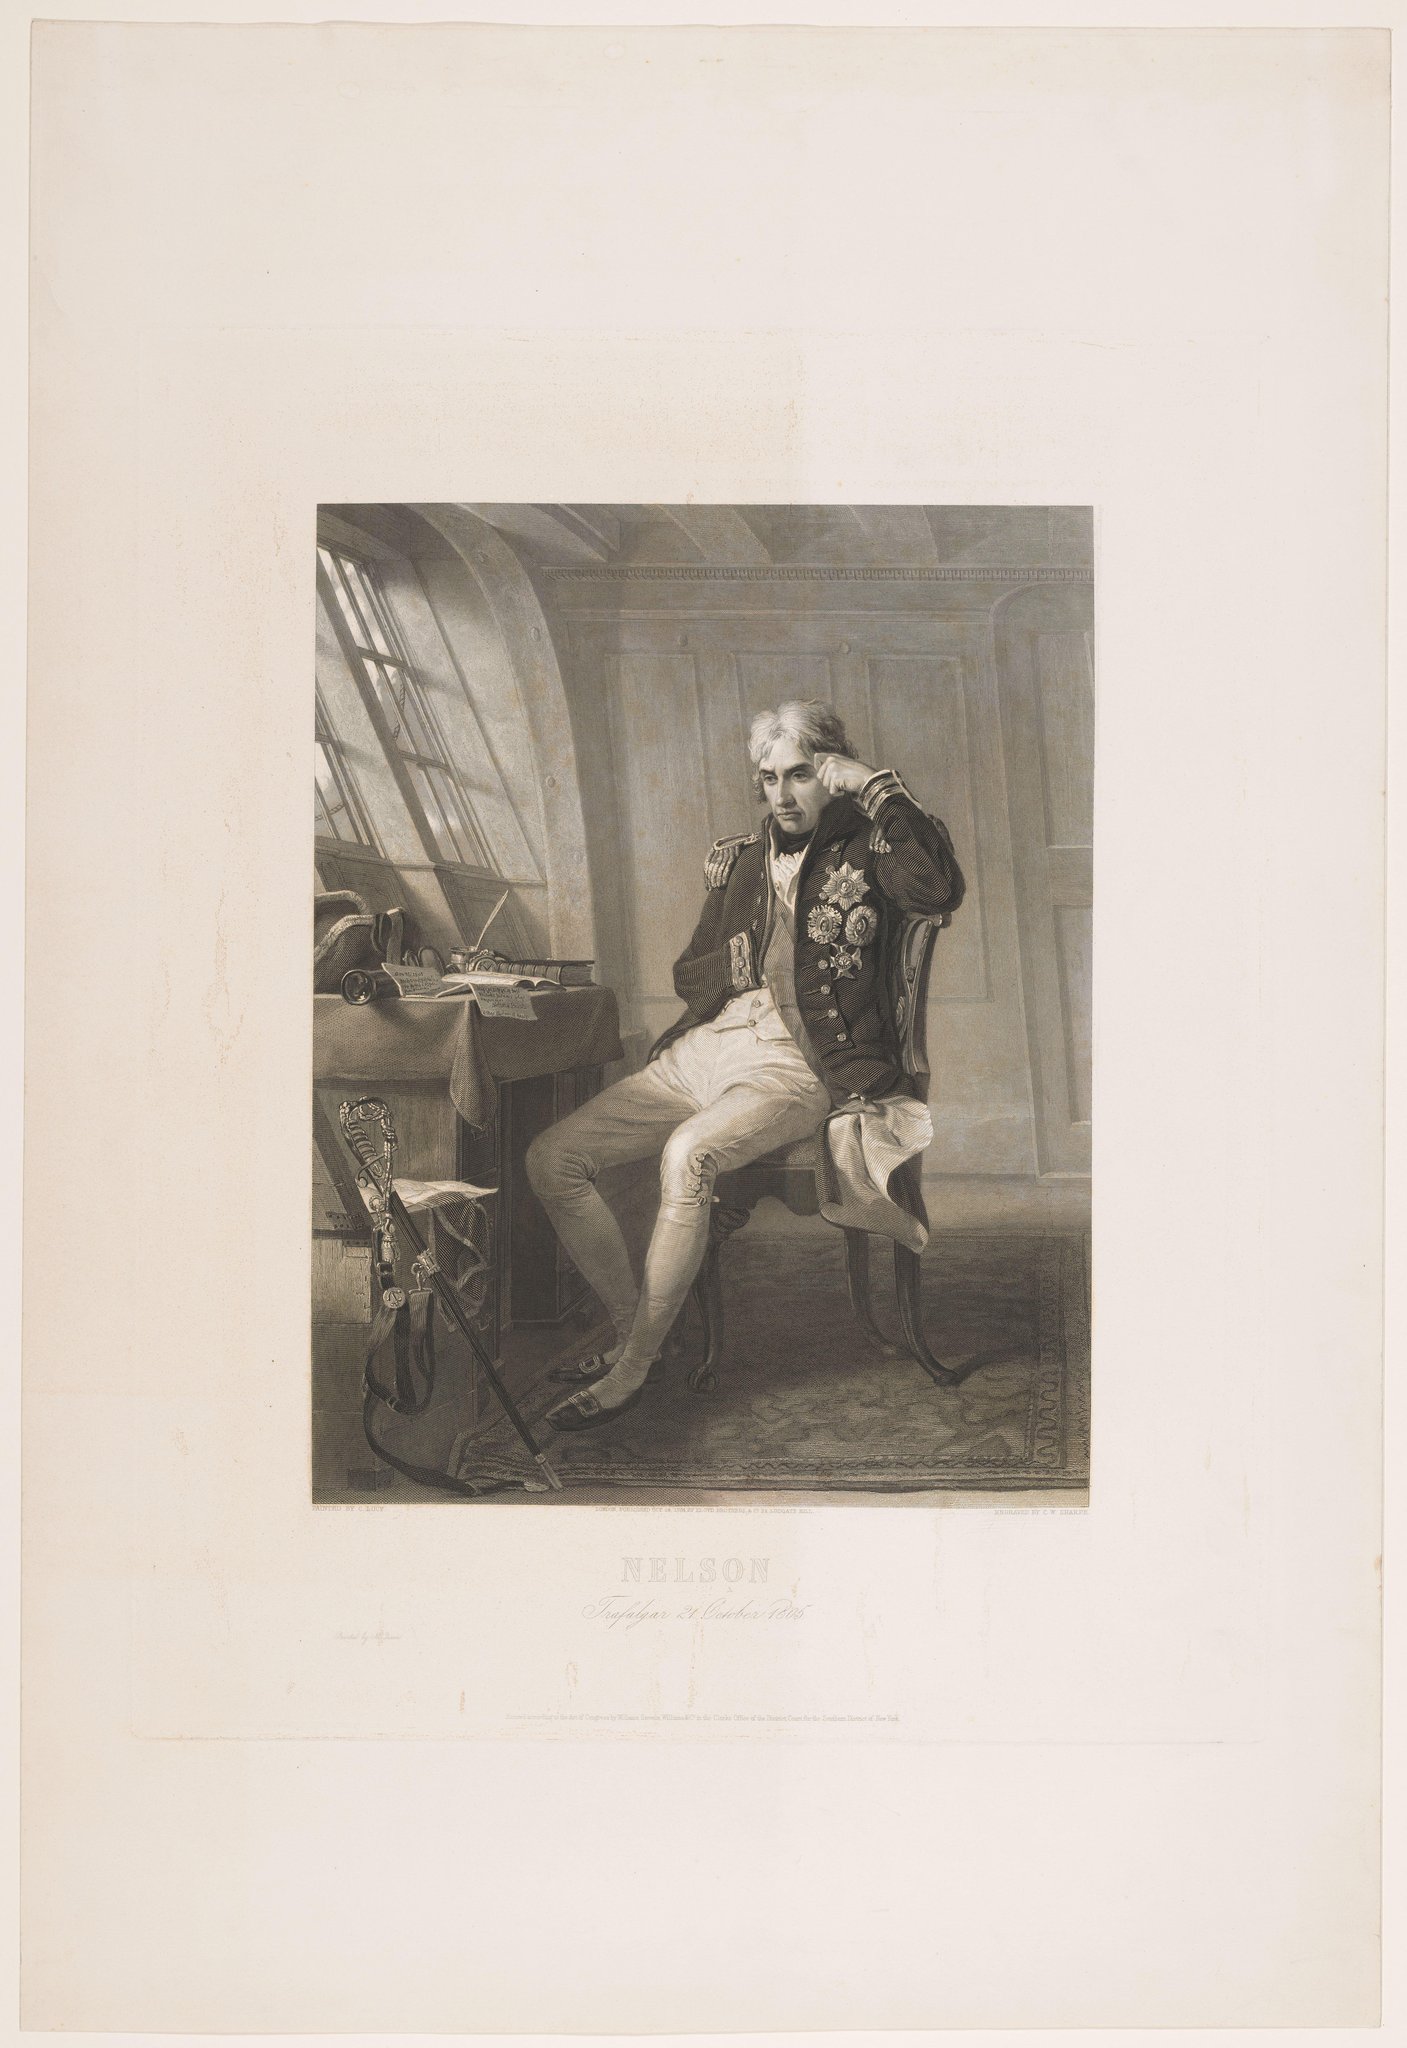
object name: print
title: Nelson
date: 1854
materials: paper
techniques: engraving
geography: england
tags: horatio nelson (hertog van bronte), commander-in-chief, admiral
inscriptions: collector's mark: Lugt 12